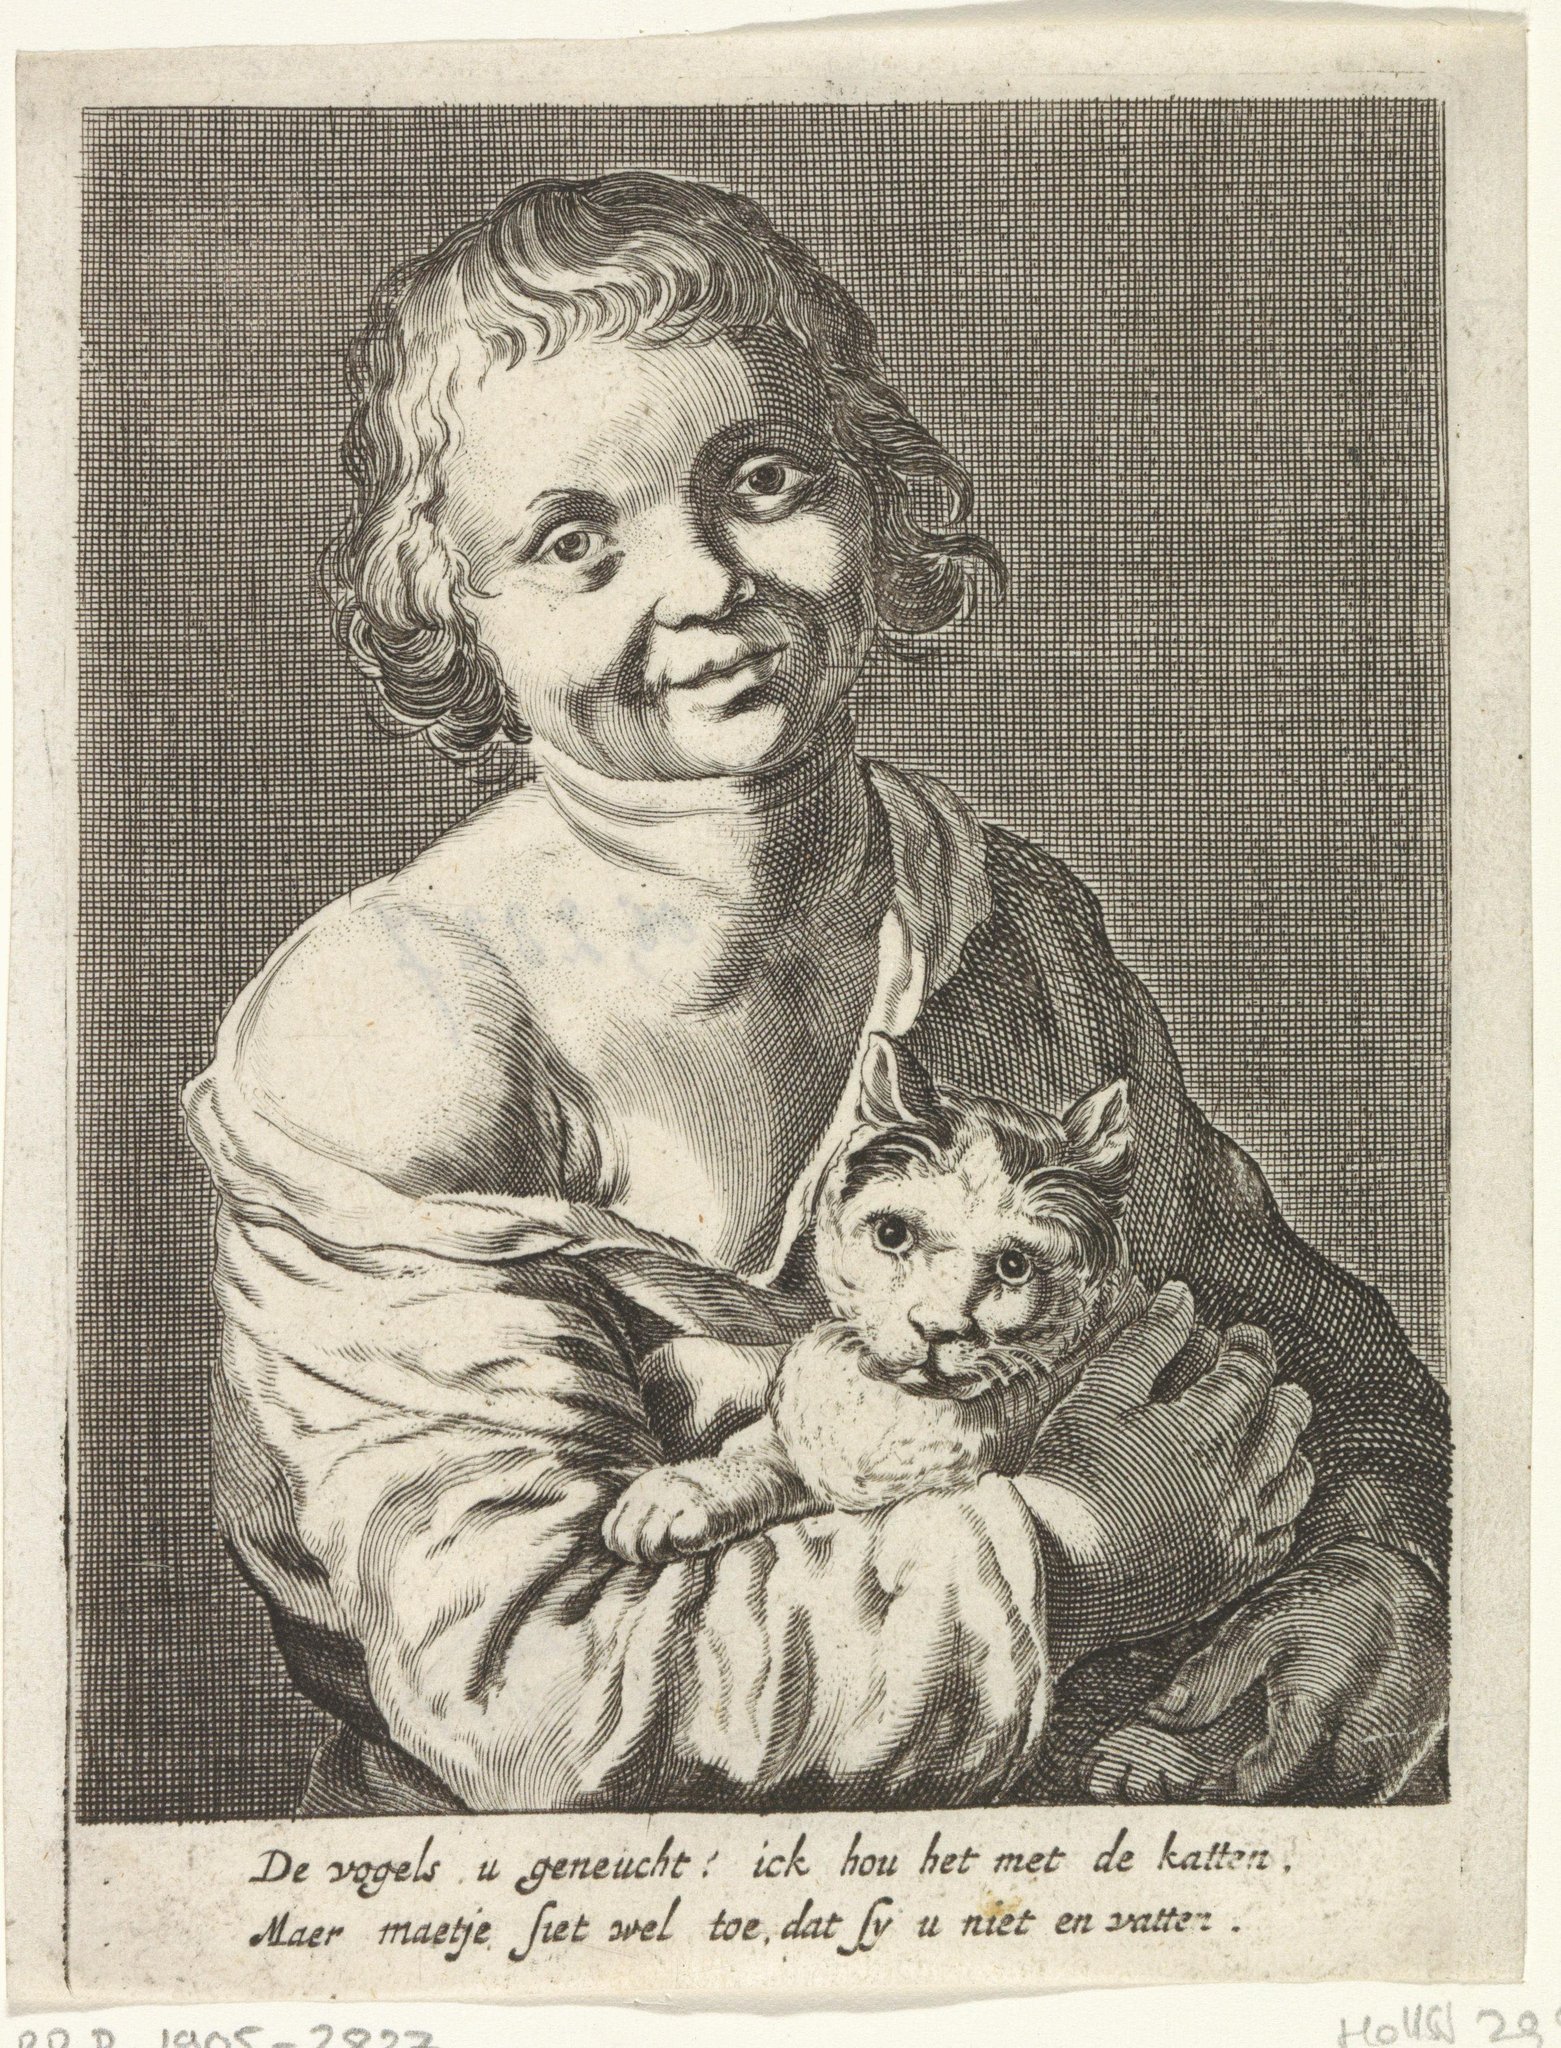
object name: print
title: Jongen met kat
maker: Anonymous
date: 1625-1675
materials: paper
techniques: engraving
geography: utrecht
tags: cat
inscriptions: collector's mark: Lugt 2228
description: Een jongen houdt een kat in de armen, dicht tegen het lichaam aan. Met tweeregelig Nederlands onderschrift, waarin wordt gewaarschuwd tegen de roofzucht van de kat (of menselijk bedrog)